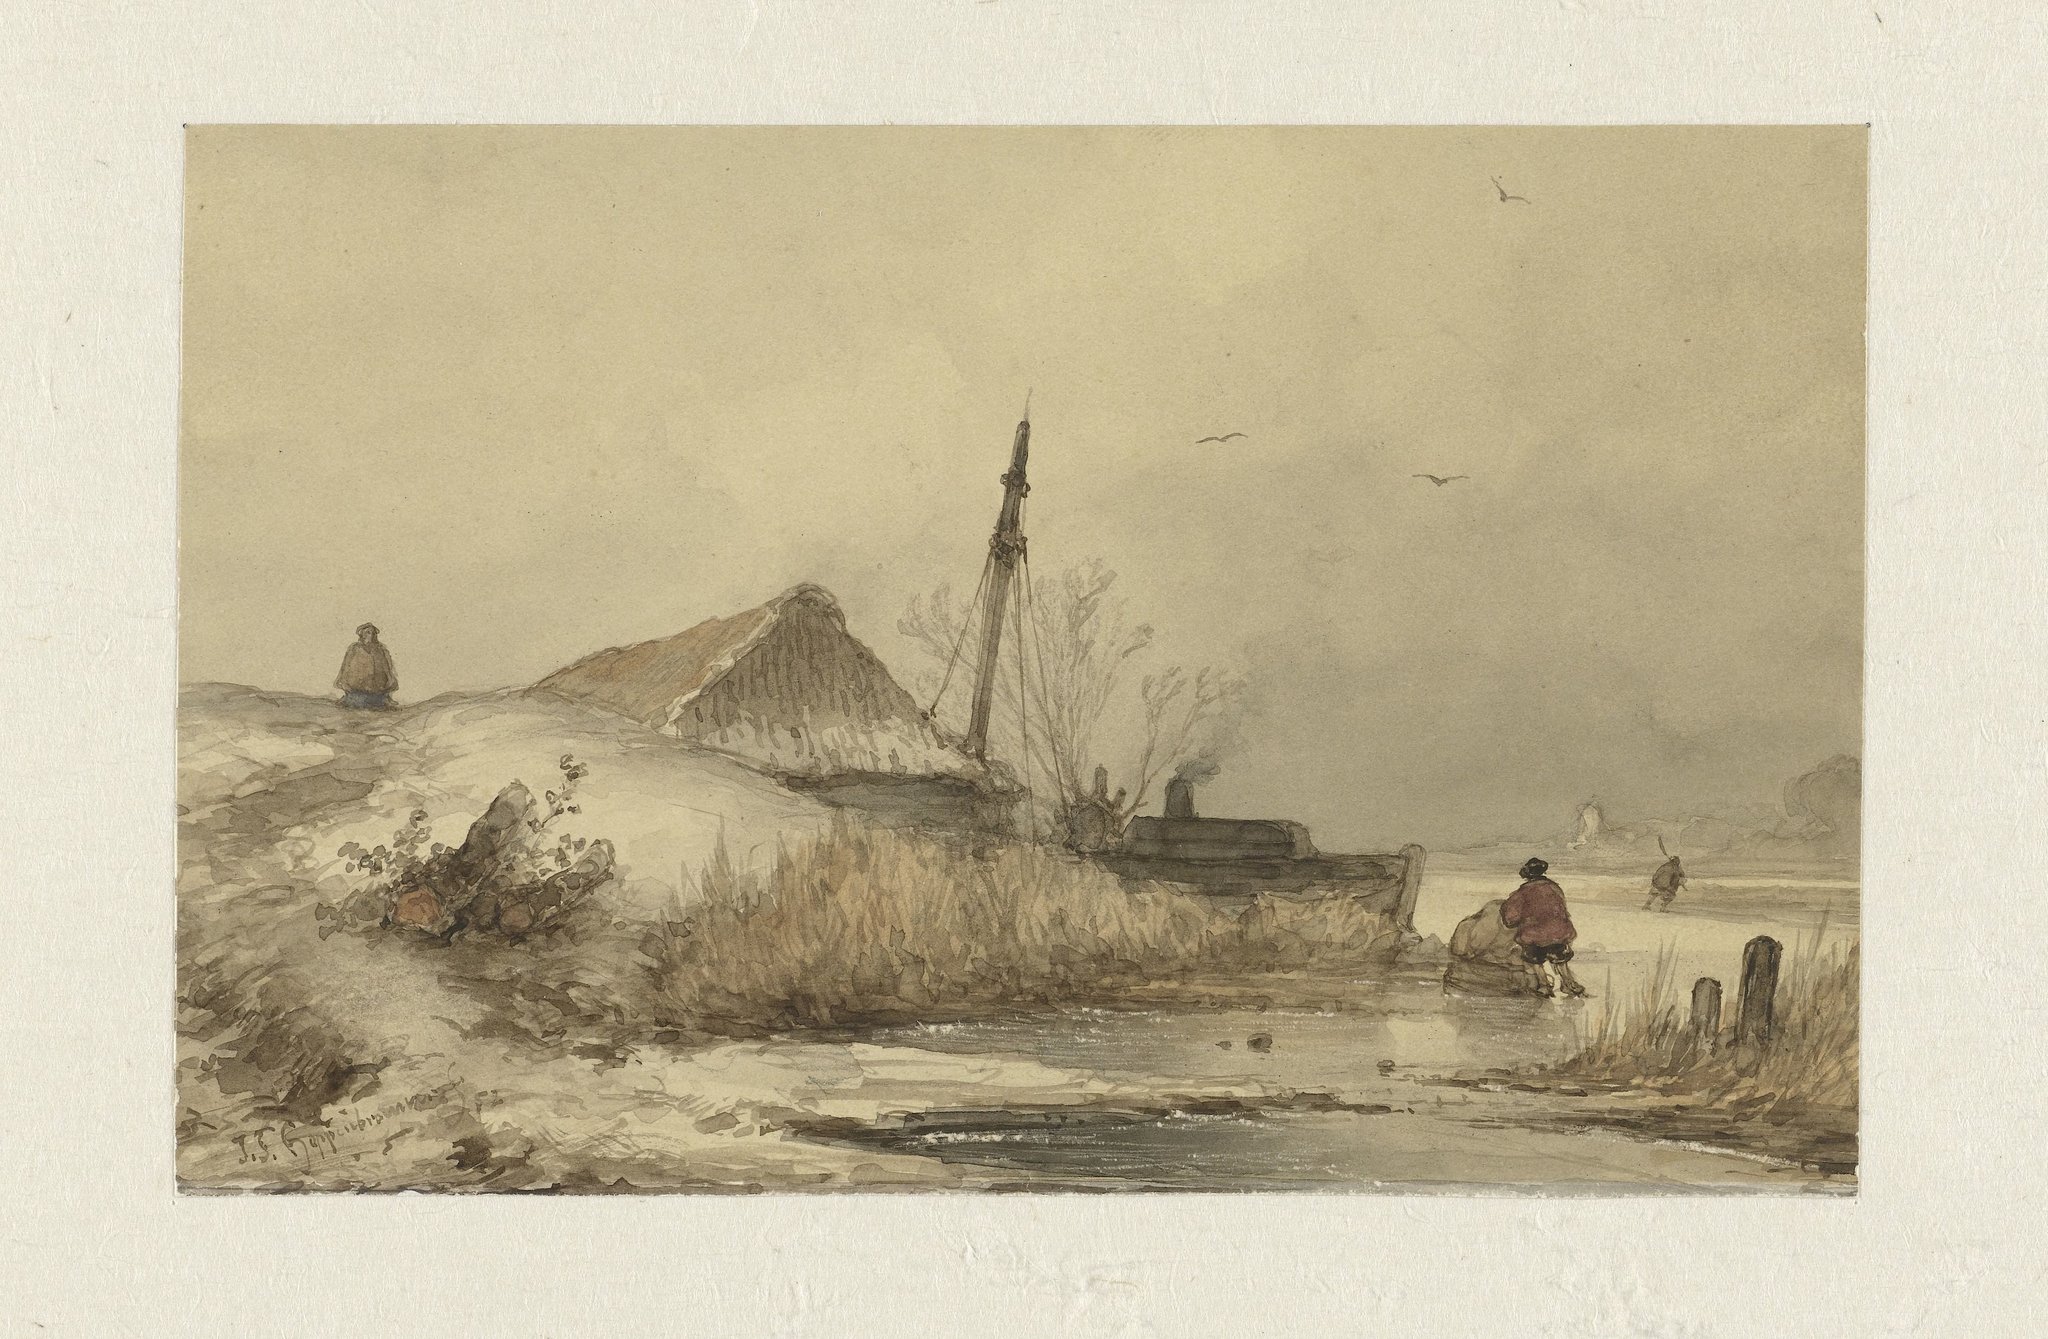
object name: drawing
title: Winterlandschap met boerderij aan sloot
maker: johannes franciscus hoppenbrouwers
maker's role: draughtsman, painter, print maker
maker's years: 1819-1866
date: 1852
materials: ink, paper, pencil, watercolor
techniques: brush, pen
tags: fluids and gases extracted from the earth